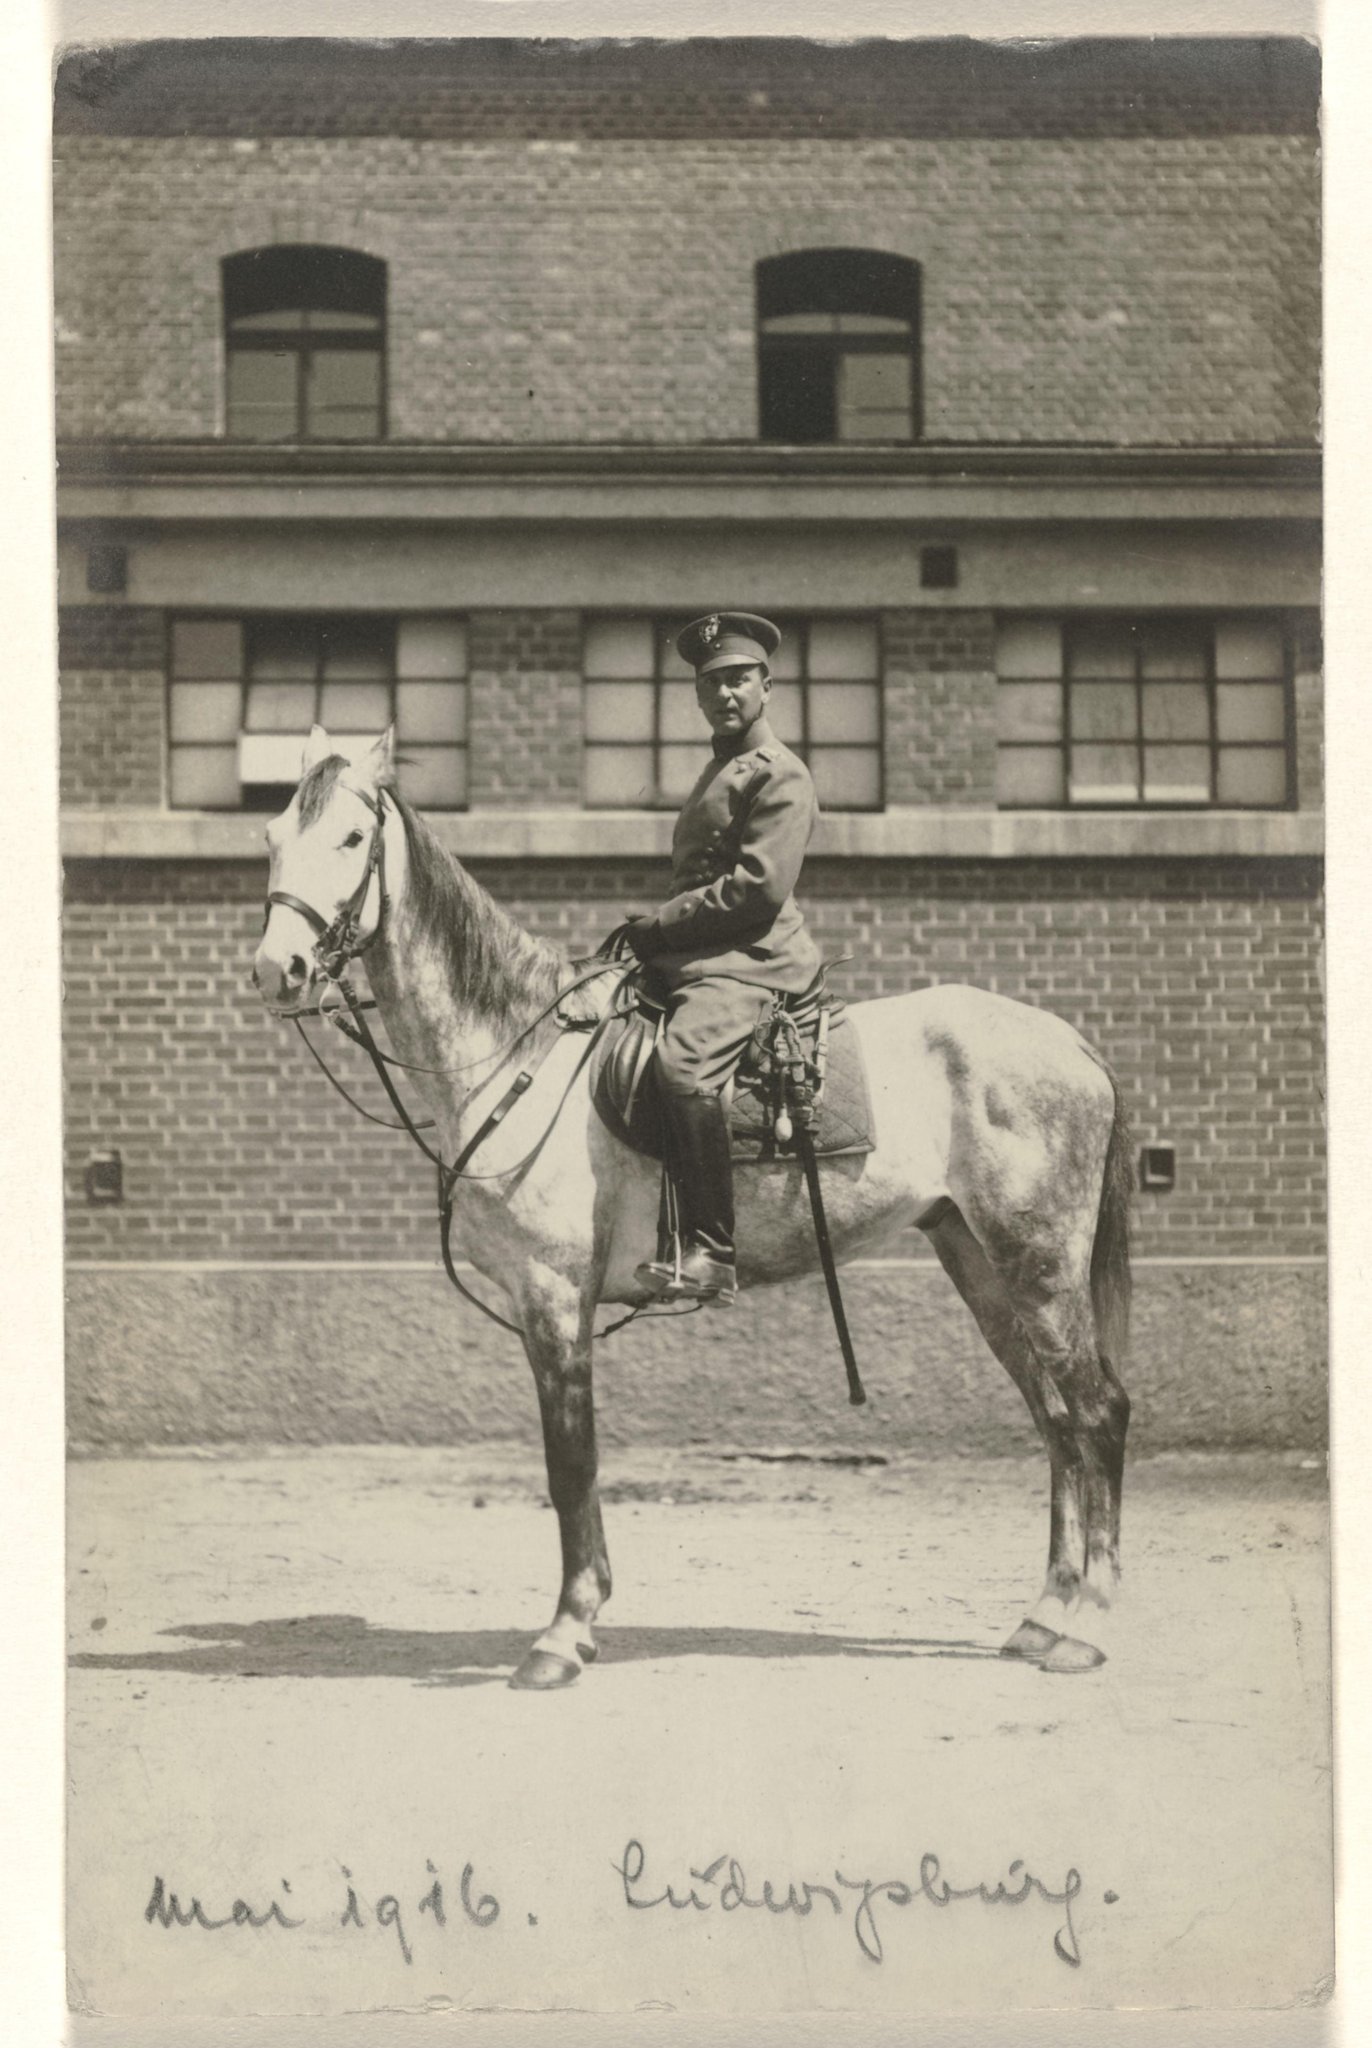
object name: photograph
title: Arthur Moos te paard in het uniform van het 20e regiment Uhlanen, mei 1916, in Ludwigsburg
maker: Anonymous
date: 1905-1916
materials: photographic support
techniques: gelatin silver print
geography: ludwigsburg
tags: arthur moos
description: Arthur Moos te paard in het uniform van het 20e regiment Uhlanen in Ludwigsburg.